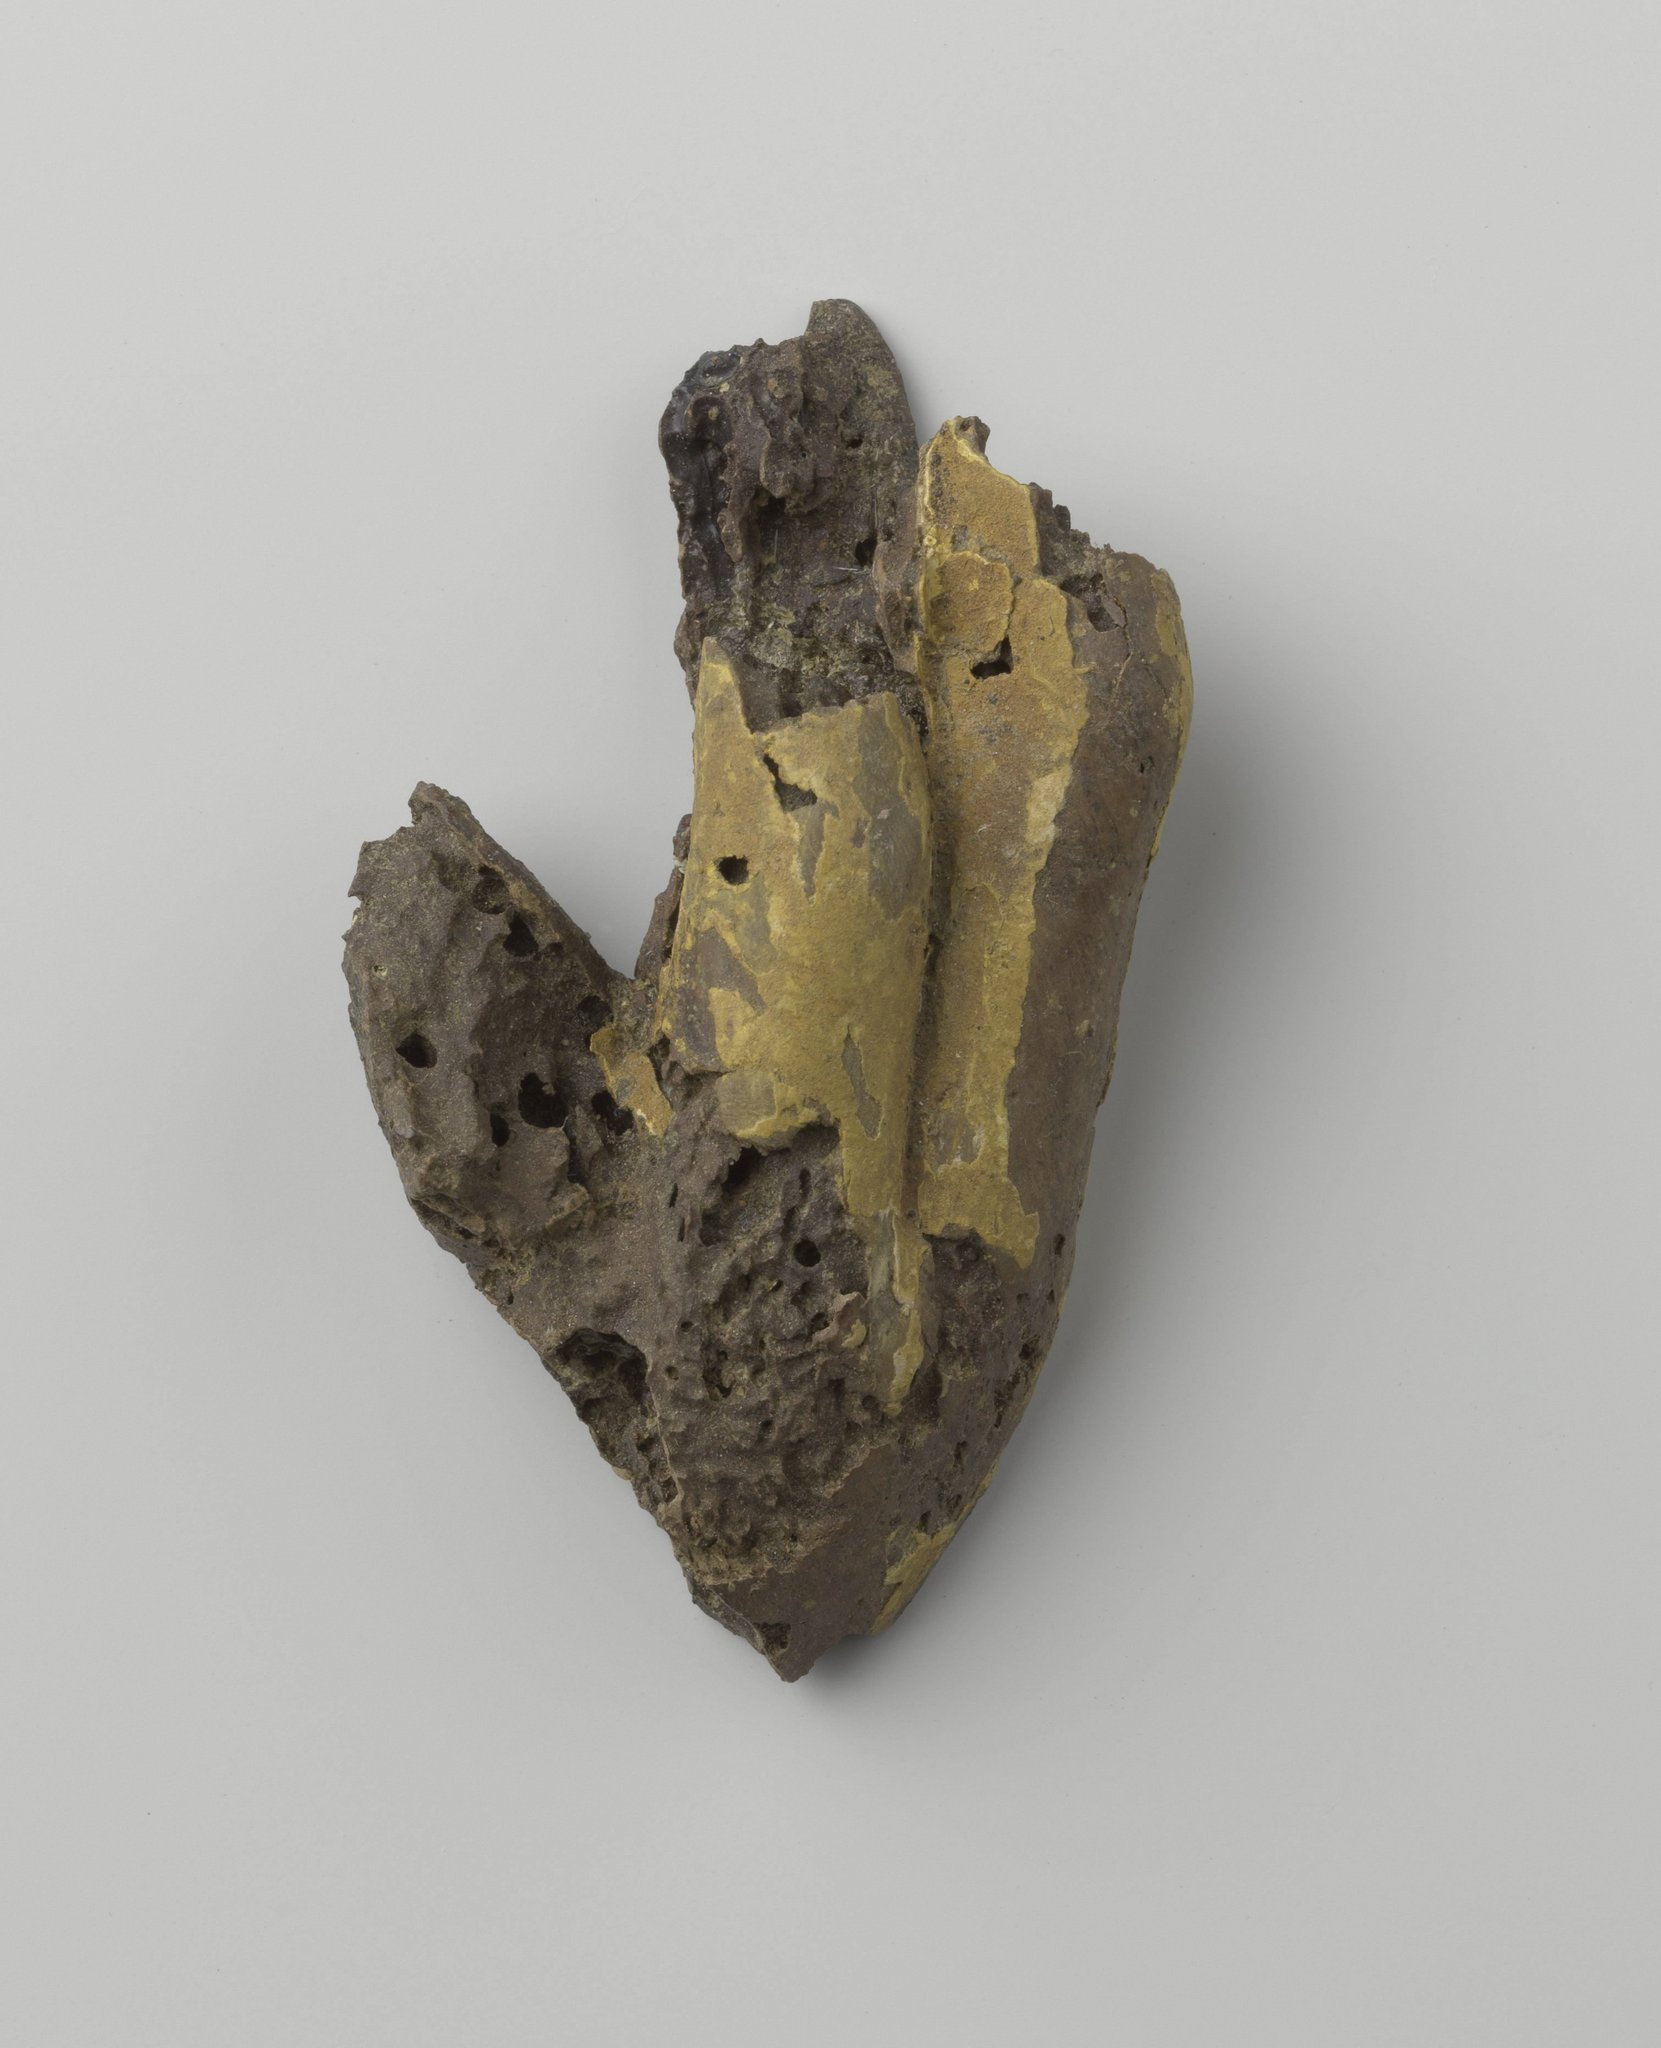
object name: sculpture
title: Fragment met resten van polychromie; (mogelijk) behorend tot het retabel van Soest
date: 1475-1499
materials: wood